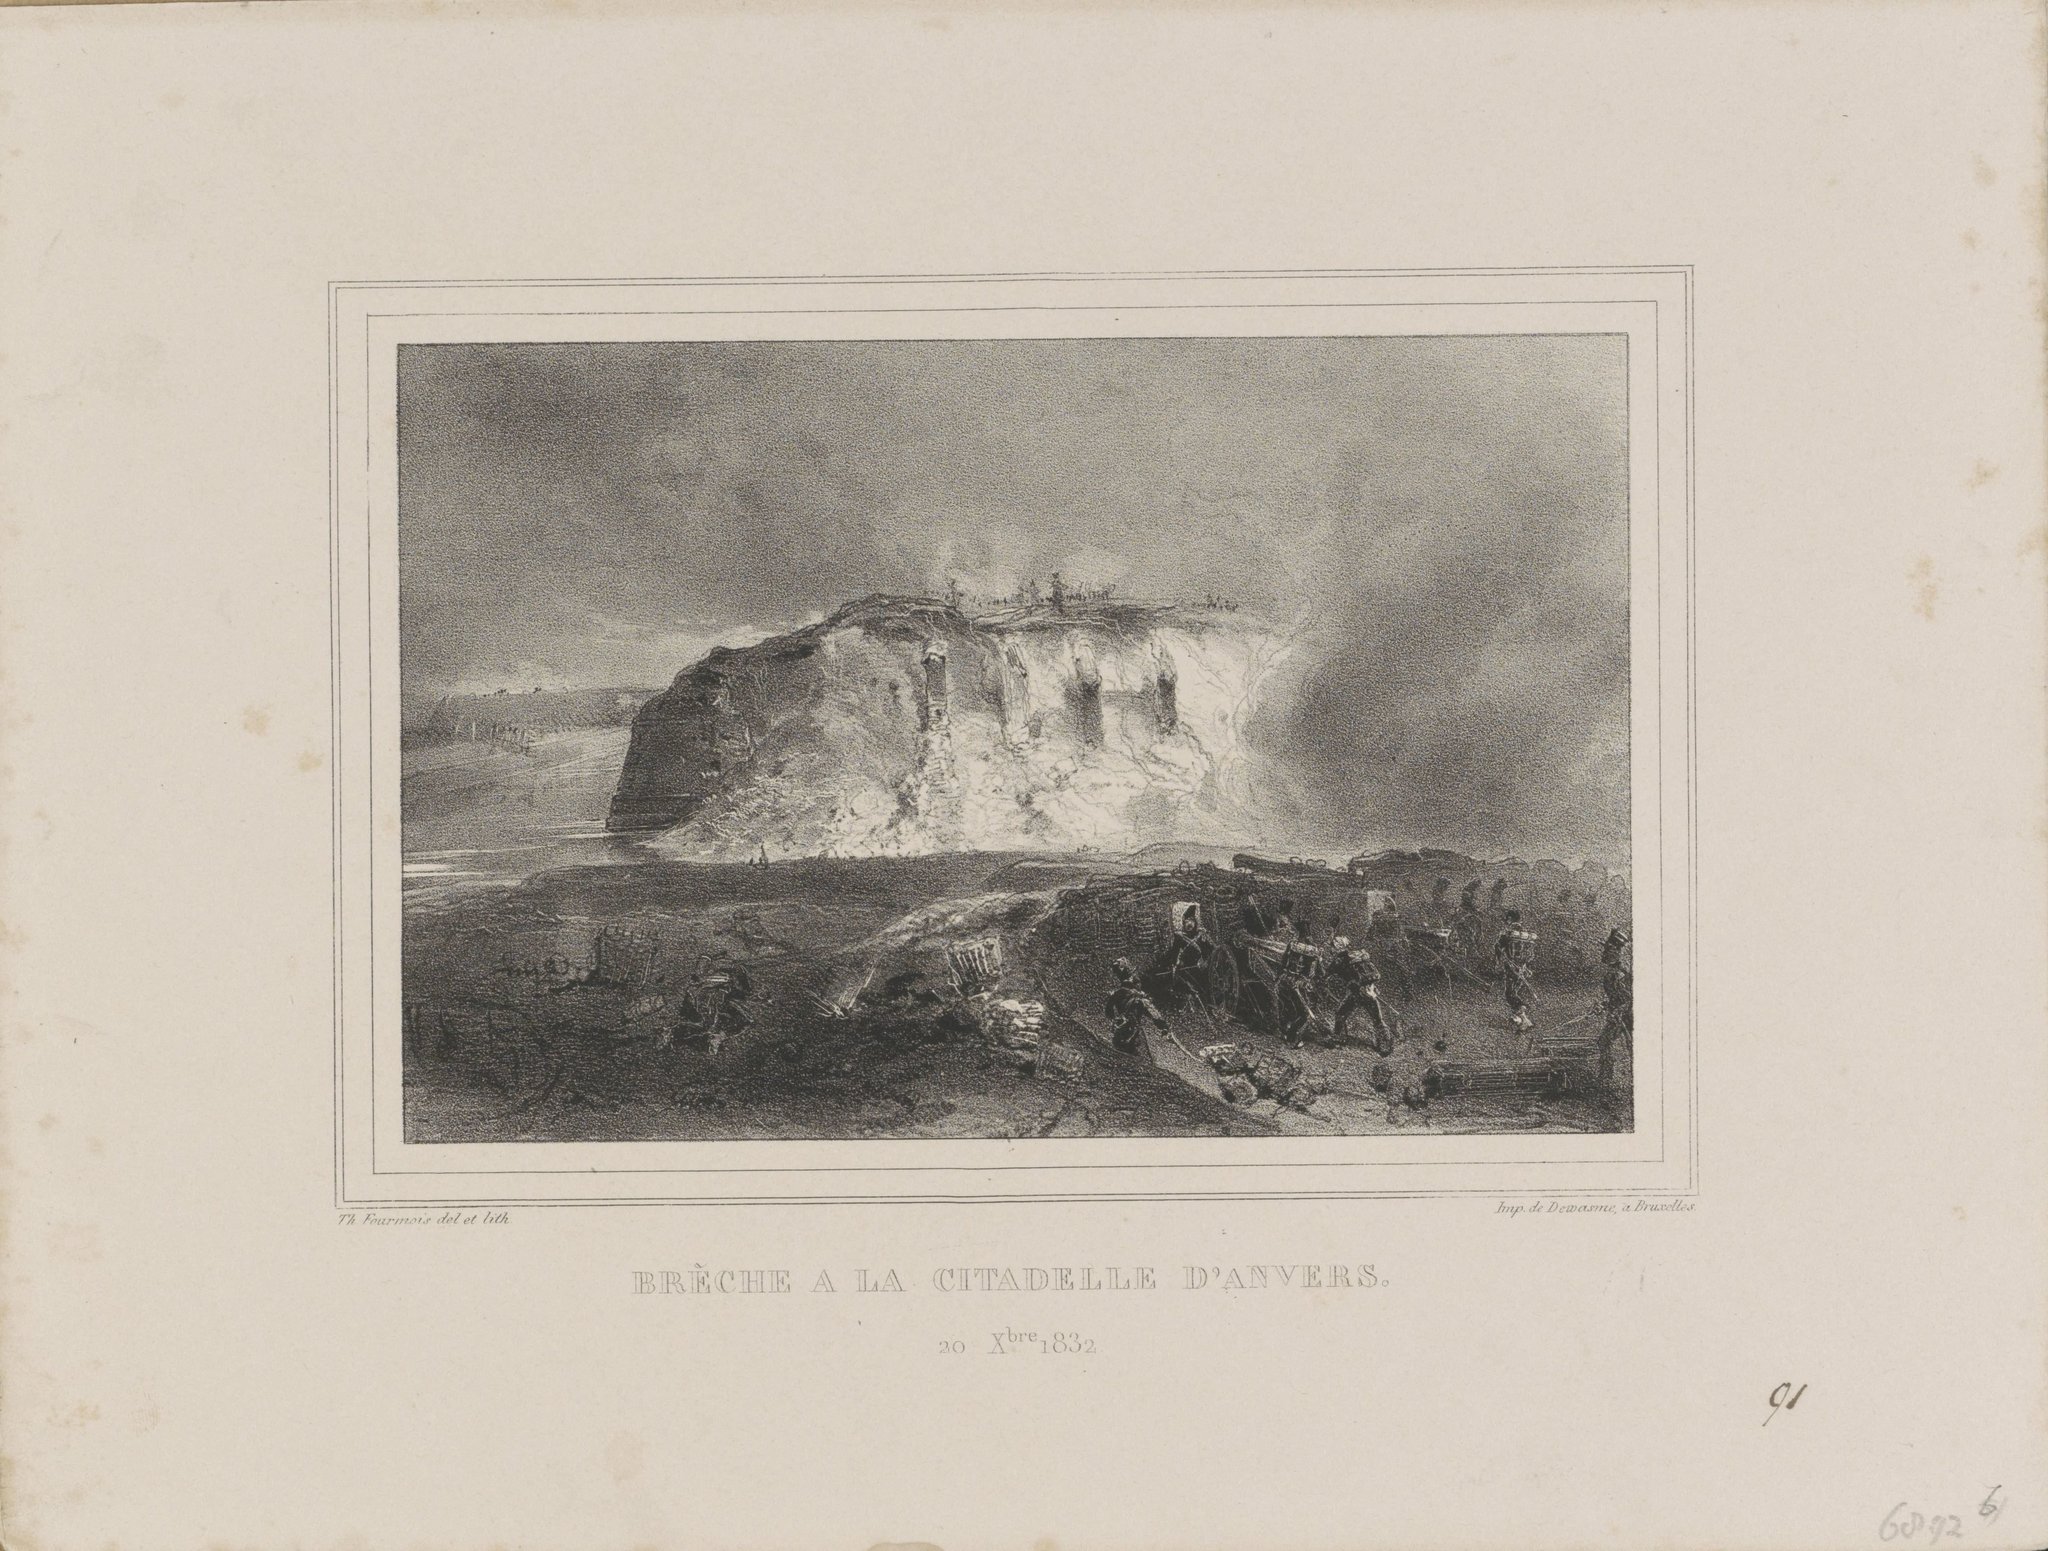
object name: print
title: Six Vues des Ruines de la Citadelle d'Anvers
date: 1833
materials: paper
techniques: lithograph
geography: brussels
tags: permanent fortifications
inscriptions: collector's mark: Lugt 2228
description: Een bres in de muren van de citadel tijdens het beleg, 1832. Onderdeel van een serie van zes platen uit 1833 van de ruïnes van de citadel na het beleg door het Franse leger in november en december 1832.